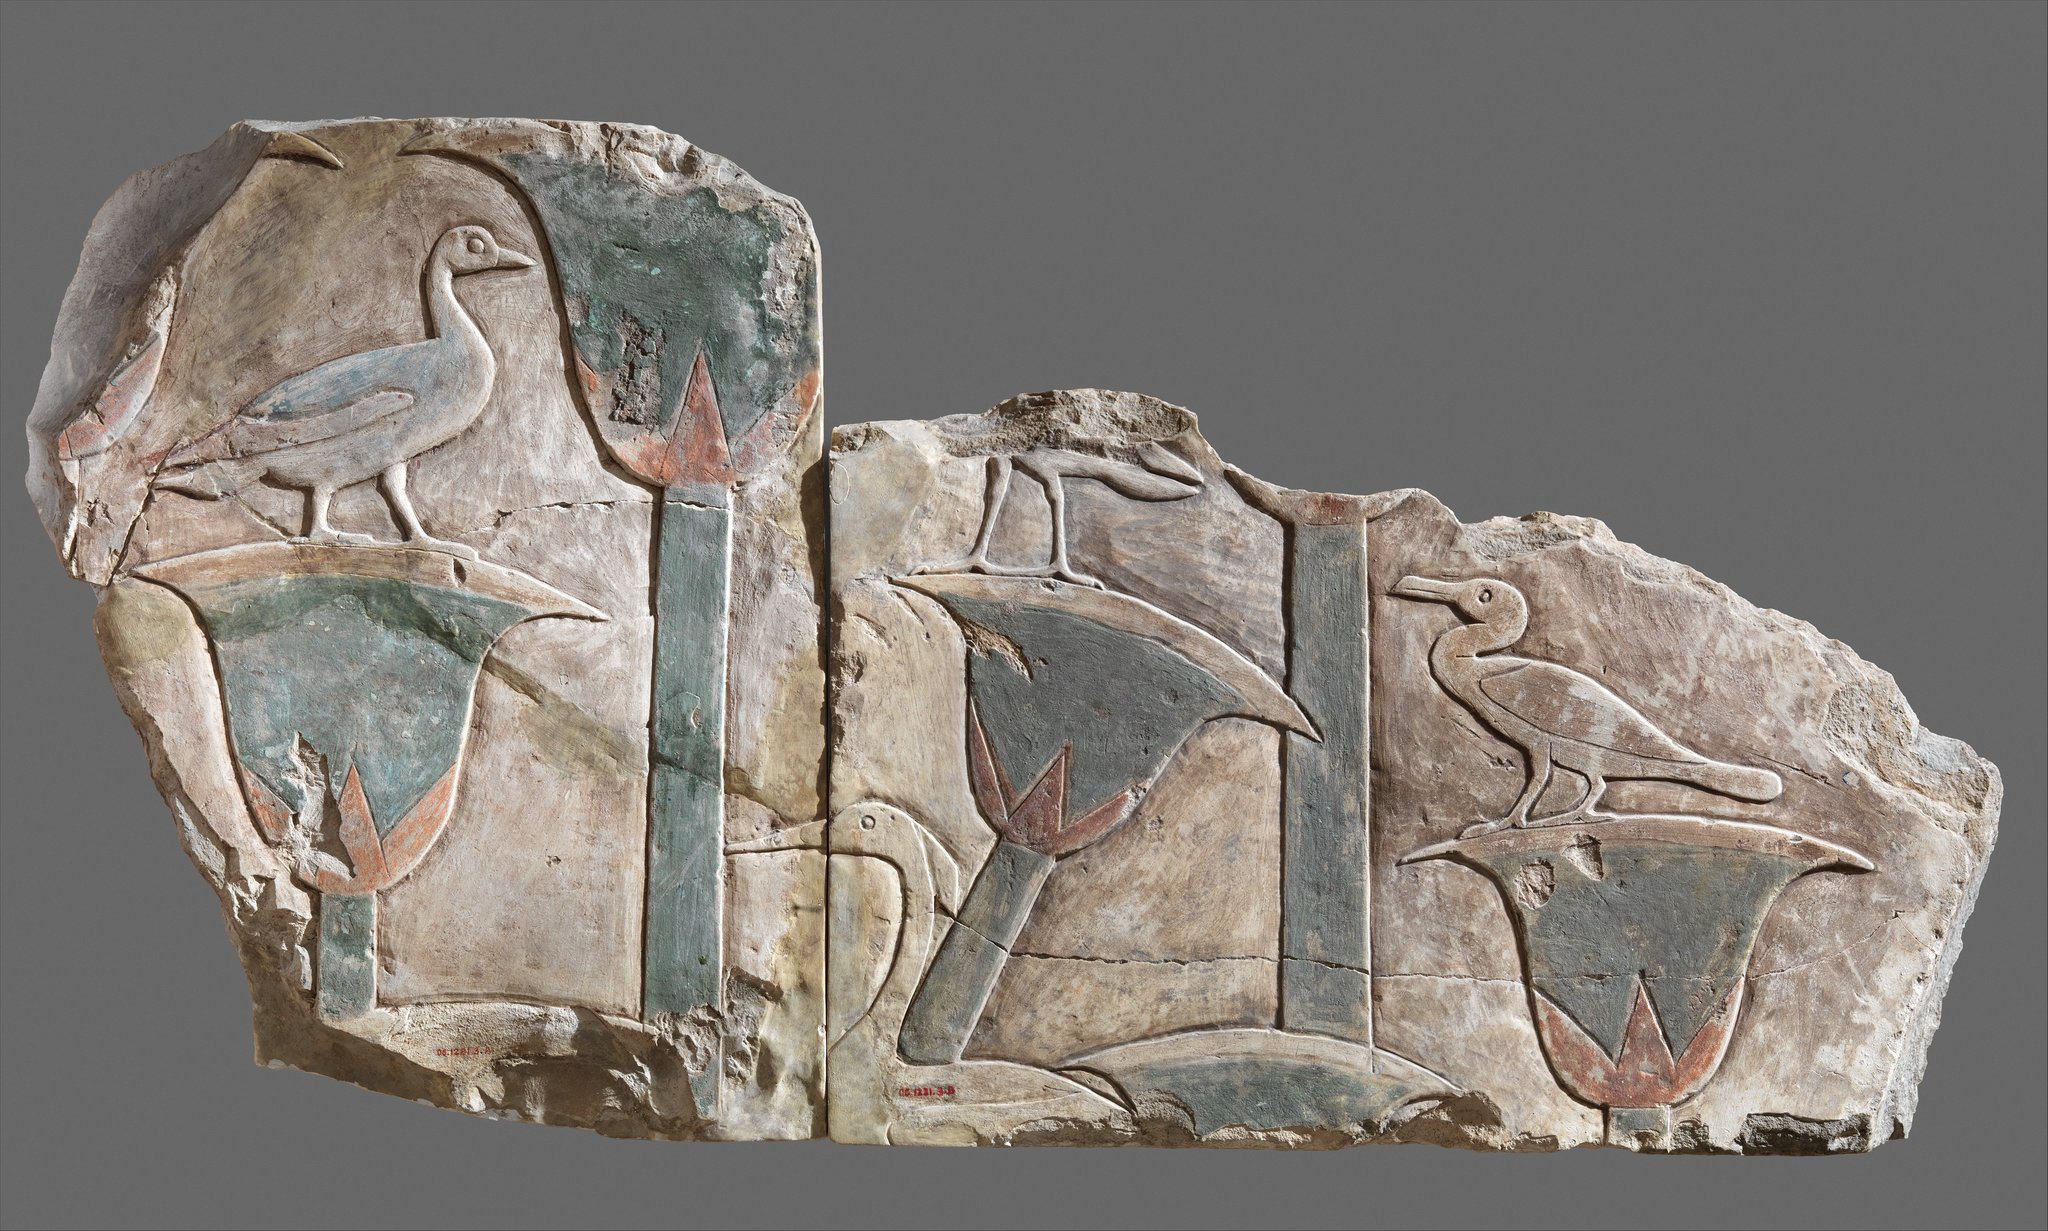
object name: relief, bird, papyrus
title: Relief with Birds in the Papyrus Thicket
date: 2030-2000 BCE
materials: limestone, paint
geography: egypt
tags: birds,flowers